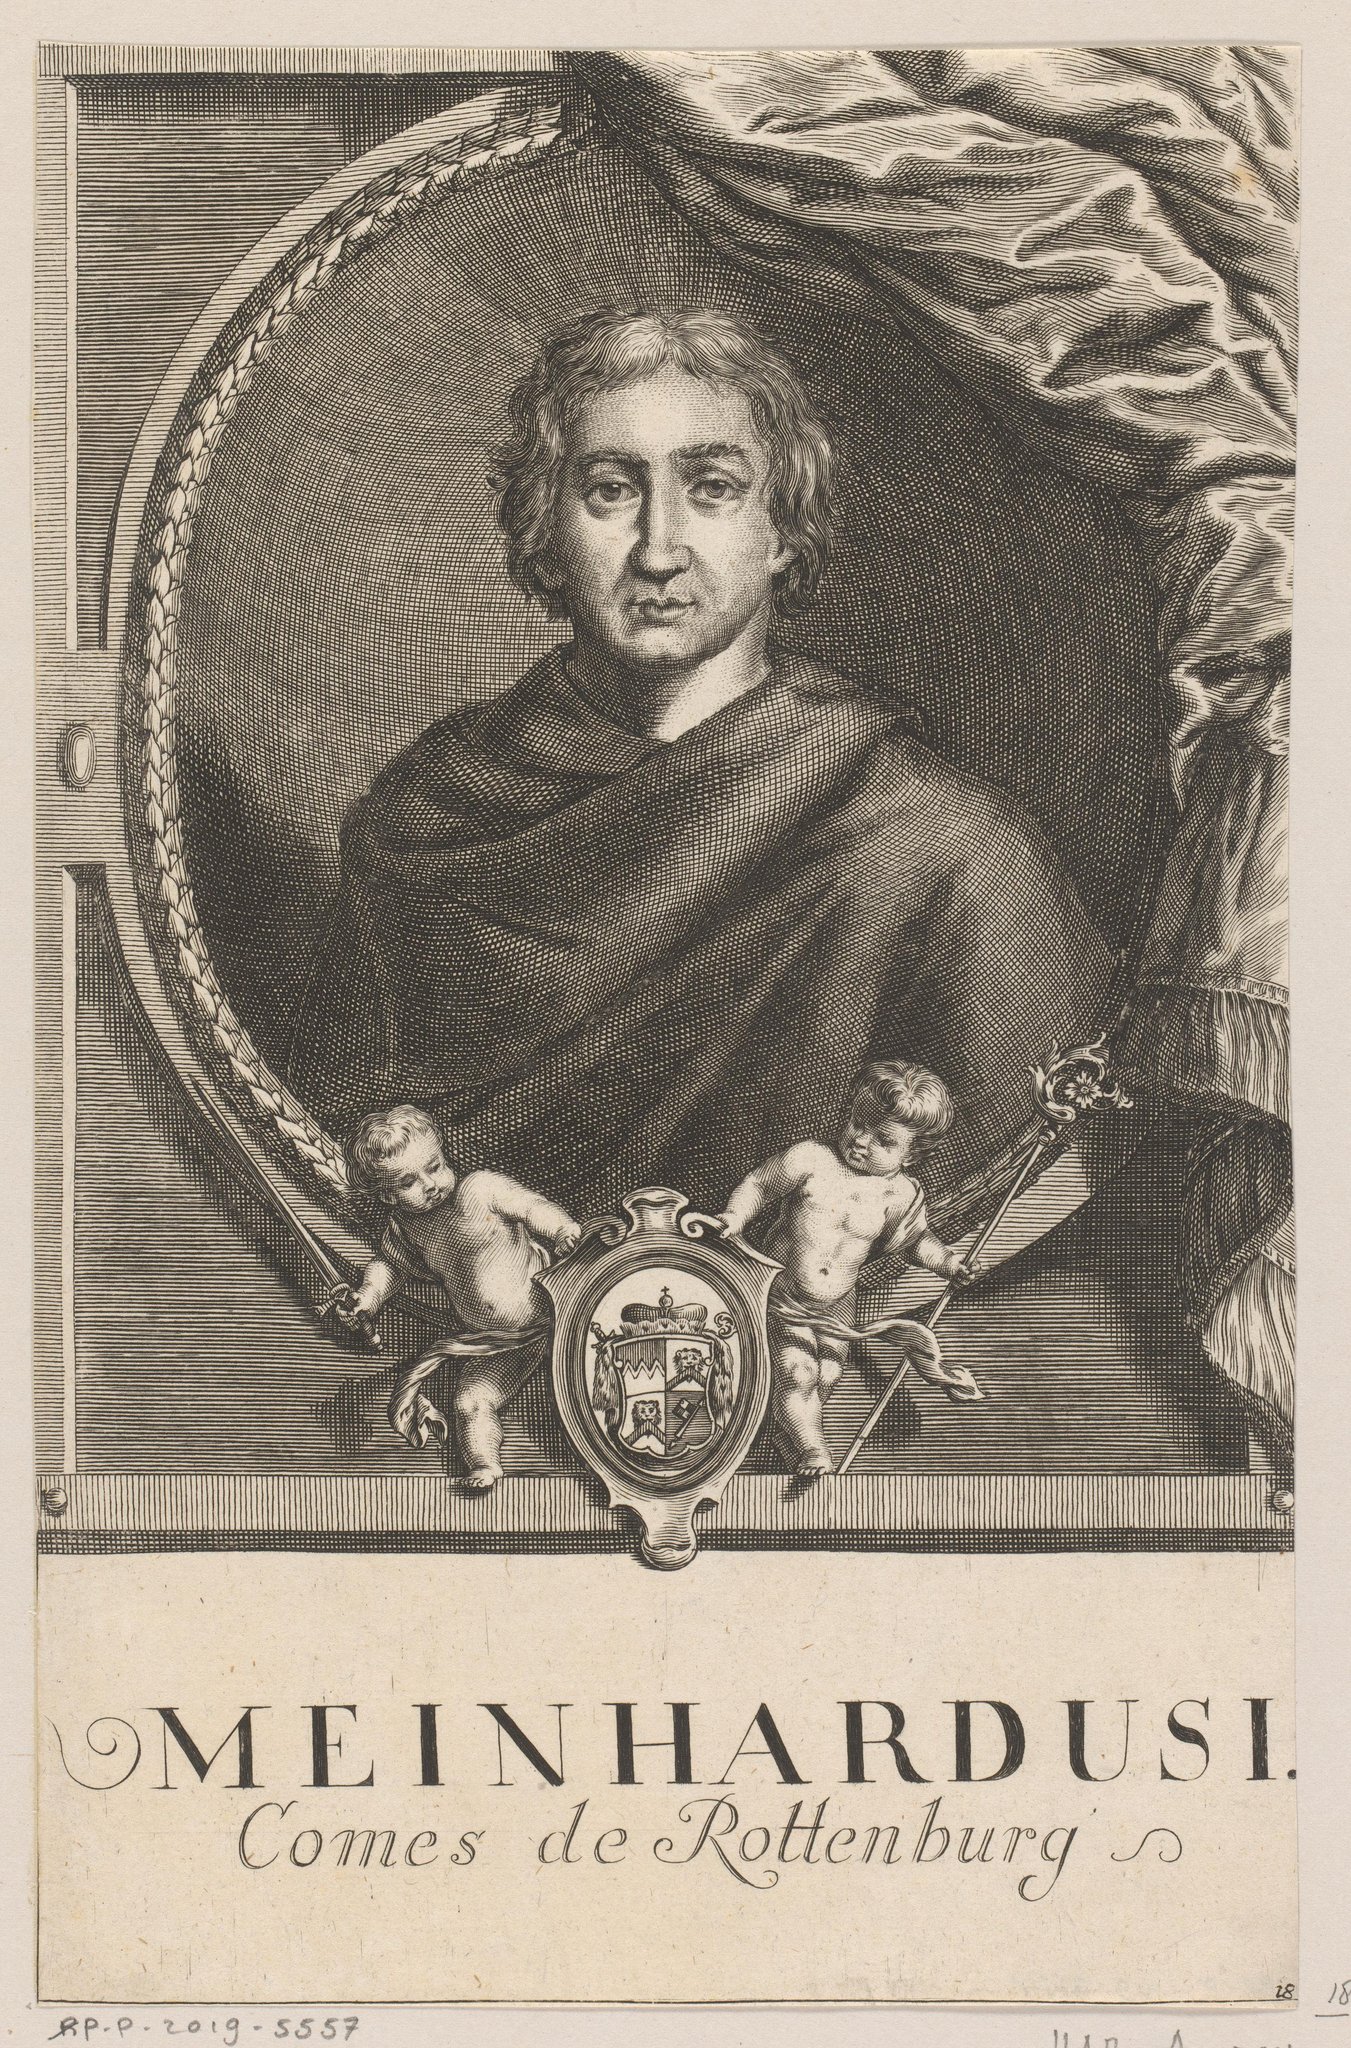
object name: book illustration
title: Meinhardus I comes de Rottenburg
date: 1713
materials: paper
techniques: engraving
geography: frankfurt am main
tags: archbishop, bishop, etc. (roman catholic), historical persons, armorial bearing, heraldry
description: Prent uit: Ludewig, Johann Peter von. Geschicht-Schreiber von dem Bischoffthum Wirtzburg (...). Frankfurt am Main: Thomas Fritsch, 1713.